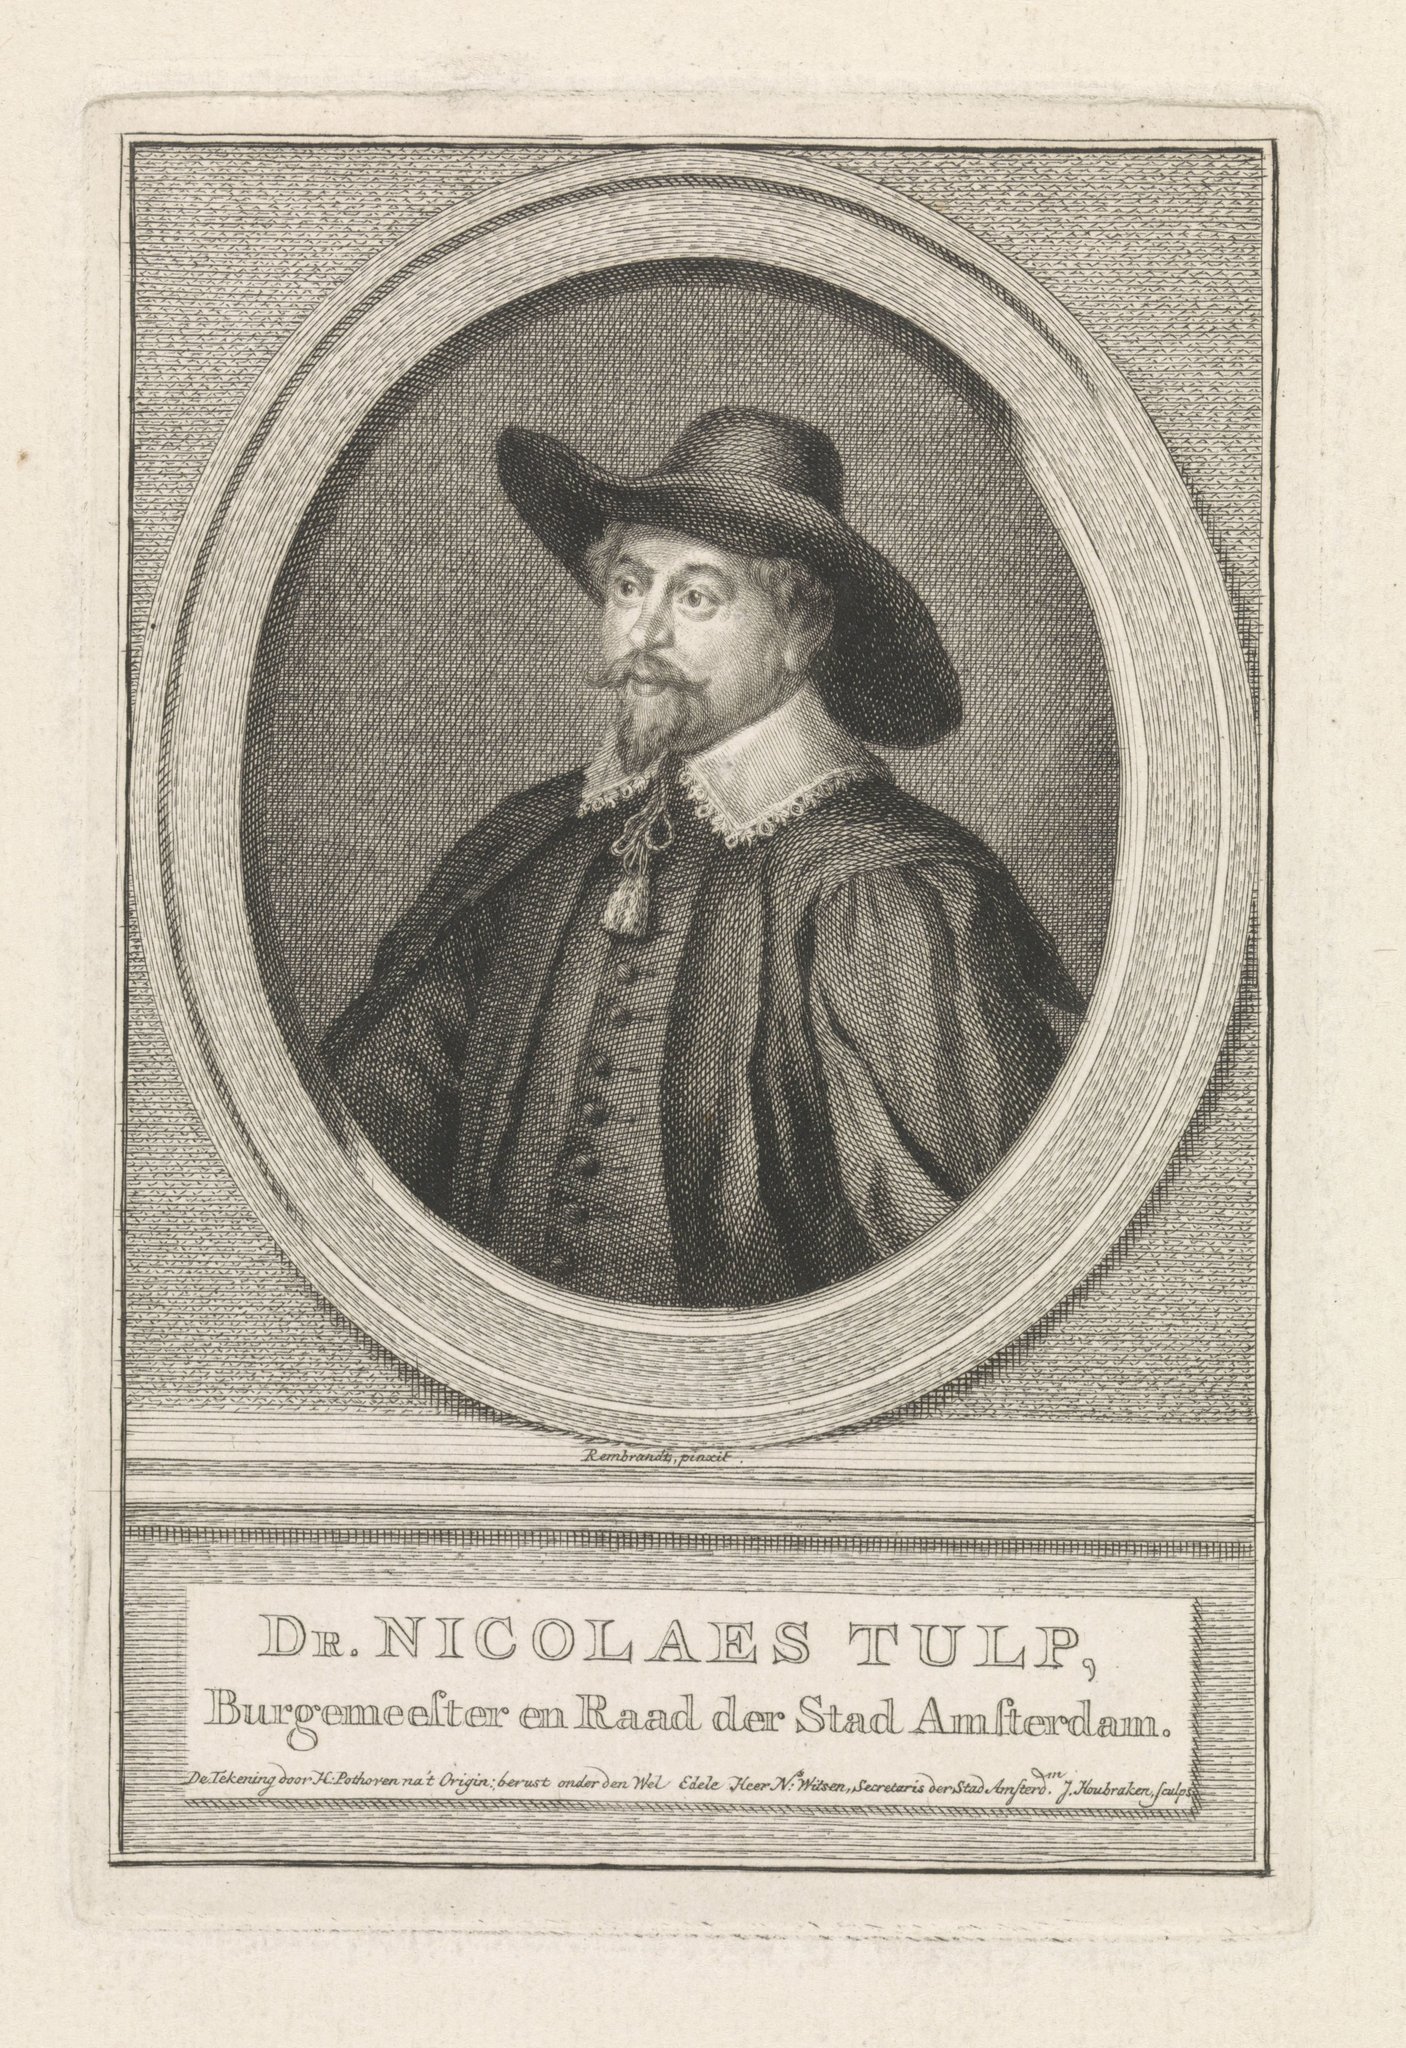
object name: print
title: Portret van Nicolaes Tulp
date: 1749-1780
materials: paper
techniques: engraving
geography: amsterdam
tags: mayor, historical persons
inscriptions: collector's mark: Lugt 2165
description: Deze prent is oorspronkelijk bedoeld als aanvulling op Jan Wagenaars ‘Vaderlandsche historie’* en was zo vanaf 1796 verkrijgbaar bij Johannes Allart te Amsterdam. Voor de advertentie waarin Allart de 60 portretten en 7 platen, allen gegraveerd door Houbraken, ter aanvulling op Wagenaars ‘Vaderlandsche historie’ aanbiedt, zie RP-P-OB-77.766. *Van dit werk zijn in de achttiende eeuw meerdere uitgaves verschenen, zoals: Wagenaar, Jan. Vaderlandsche historie, vervattende de geschiedenissen der Vereenigde Nederlanden (…). 21 delen. Amsterdam: Isaak Tirion, 1749-1759. Wagenaar, Jan. Vaderlandsche historie, vervattende de geschiedenissen der nu Vereenigde Nederlanden (…). 21 delen. Amsterdam: weduwe Isaak Tirion, 1770. Wagenaar, Jan. Vaderlandsche historie, vervattende de geschiedenissen der nu Vereenigde Nederlanden (…). 21 delen. Amsterdam, Leiden, Dordrecht en Harlingen: P. Schouten e.a., 1782. Wagenaar, Jan. Vaderlandsche historie, vervattende de geschiedenissen der nu Vereenigde Nederlanden (…). 21 delen. Amsterdam: Johannes Allart, 1790-1796.